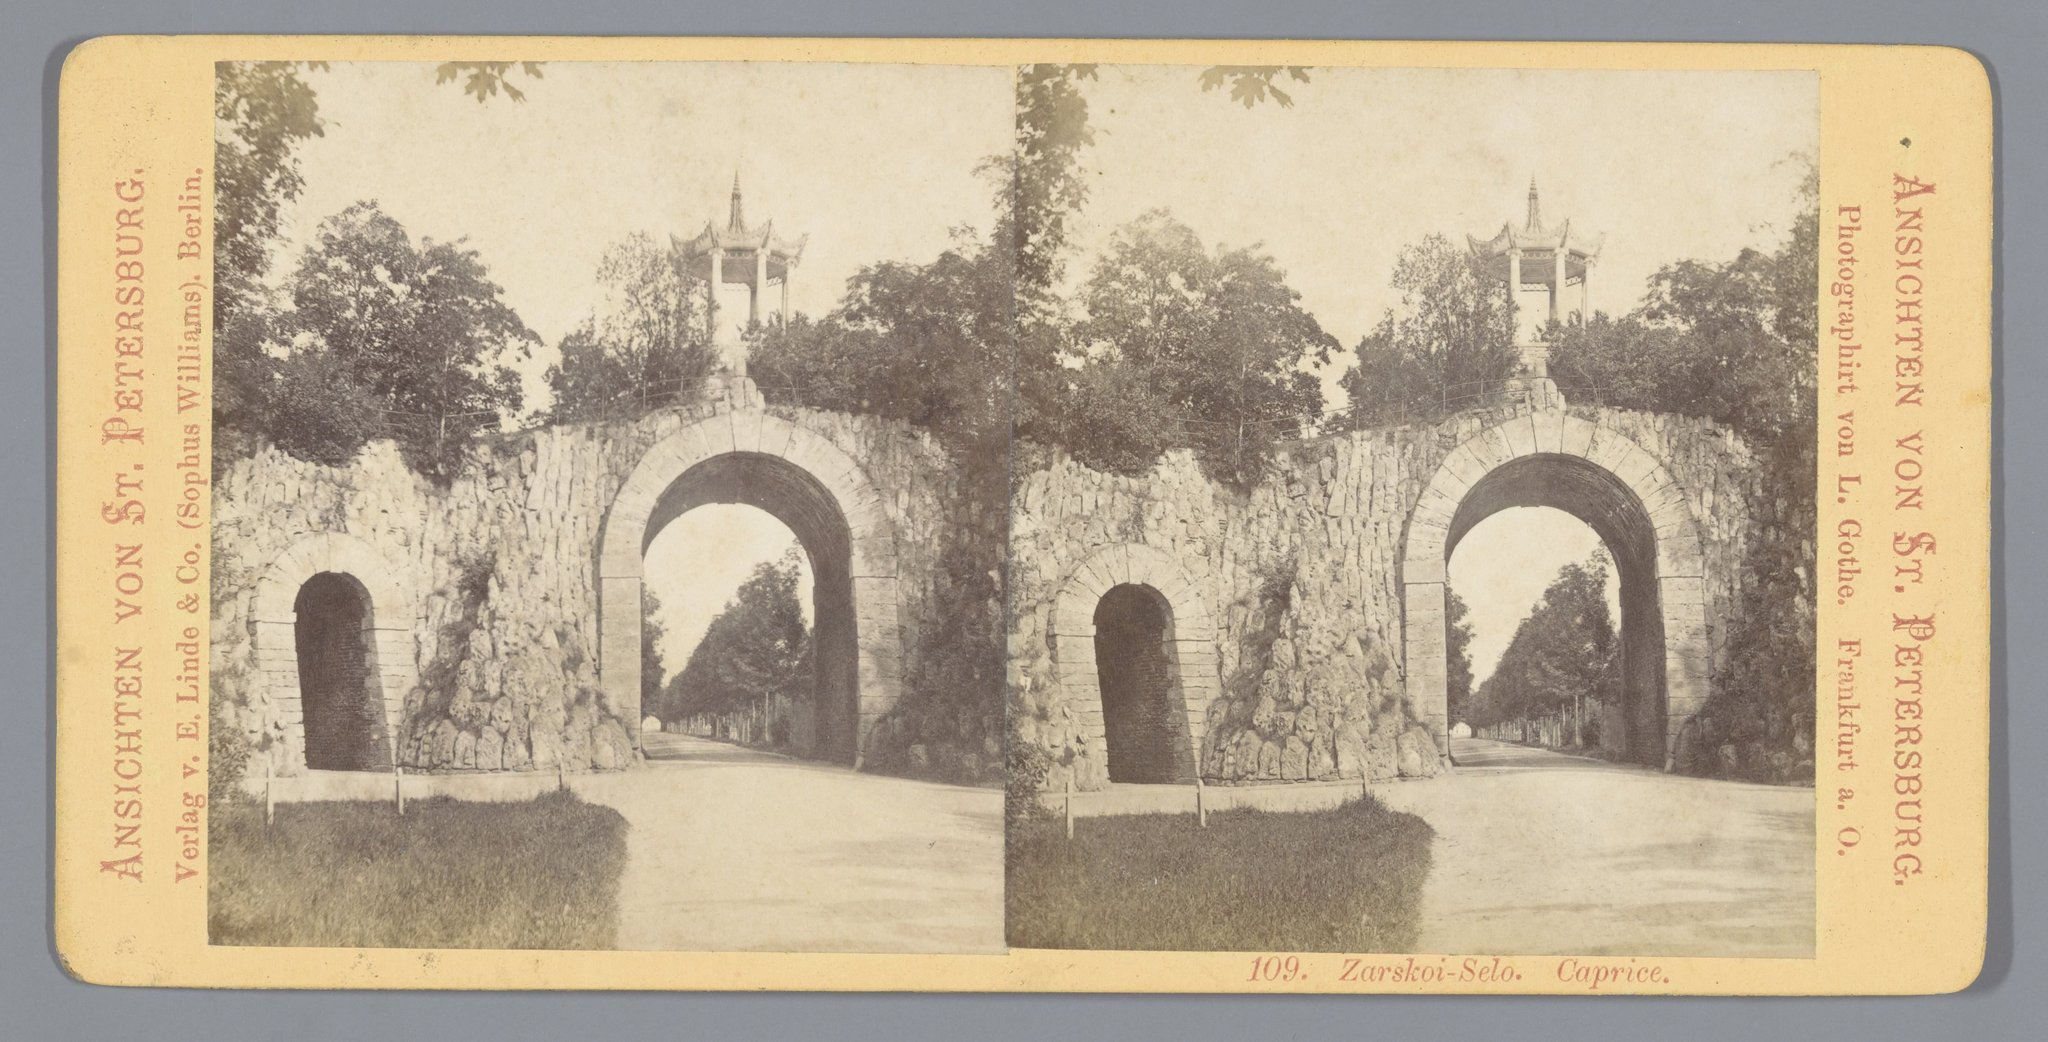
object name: stereograph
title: Zarskoi-Selo. Caprice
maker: louis gothe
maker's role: fotograaf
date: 1850-1880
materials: cardboard, photographic support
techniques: albumen print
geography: berlin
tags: tower, clock tower ~ monumental adornment, arch, archivolt ~ architecture, public gardens, park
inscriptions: inscription: ‘Ansichten von St. Petersburg.’, number: ‘109.’